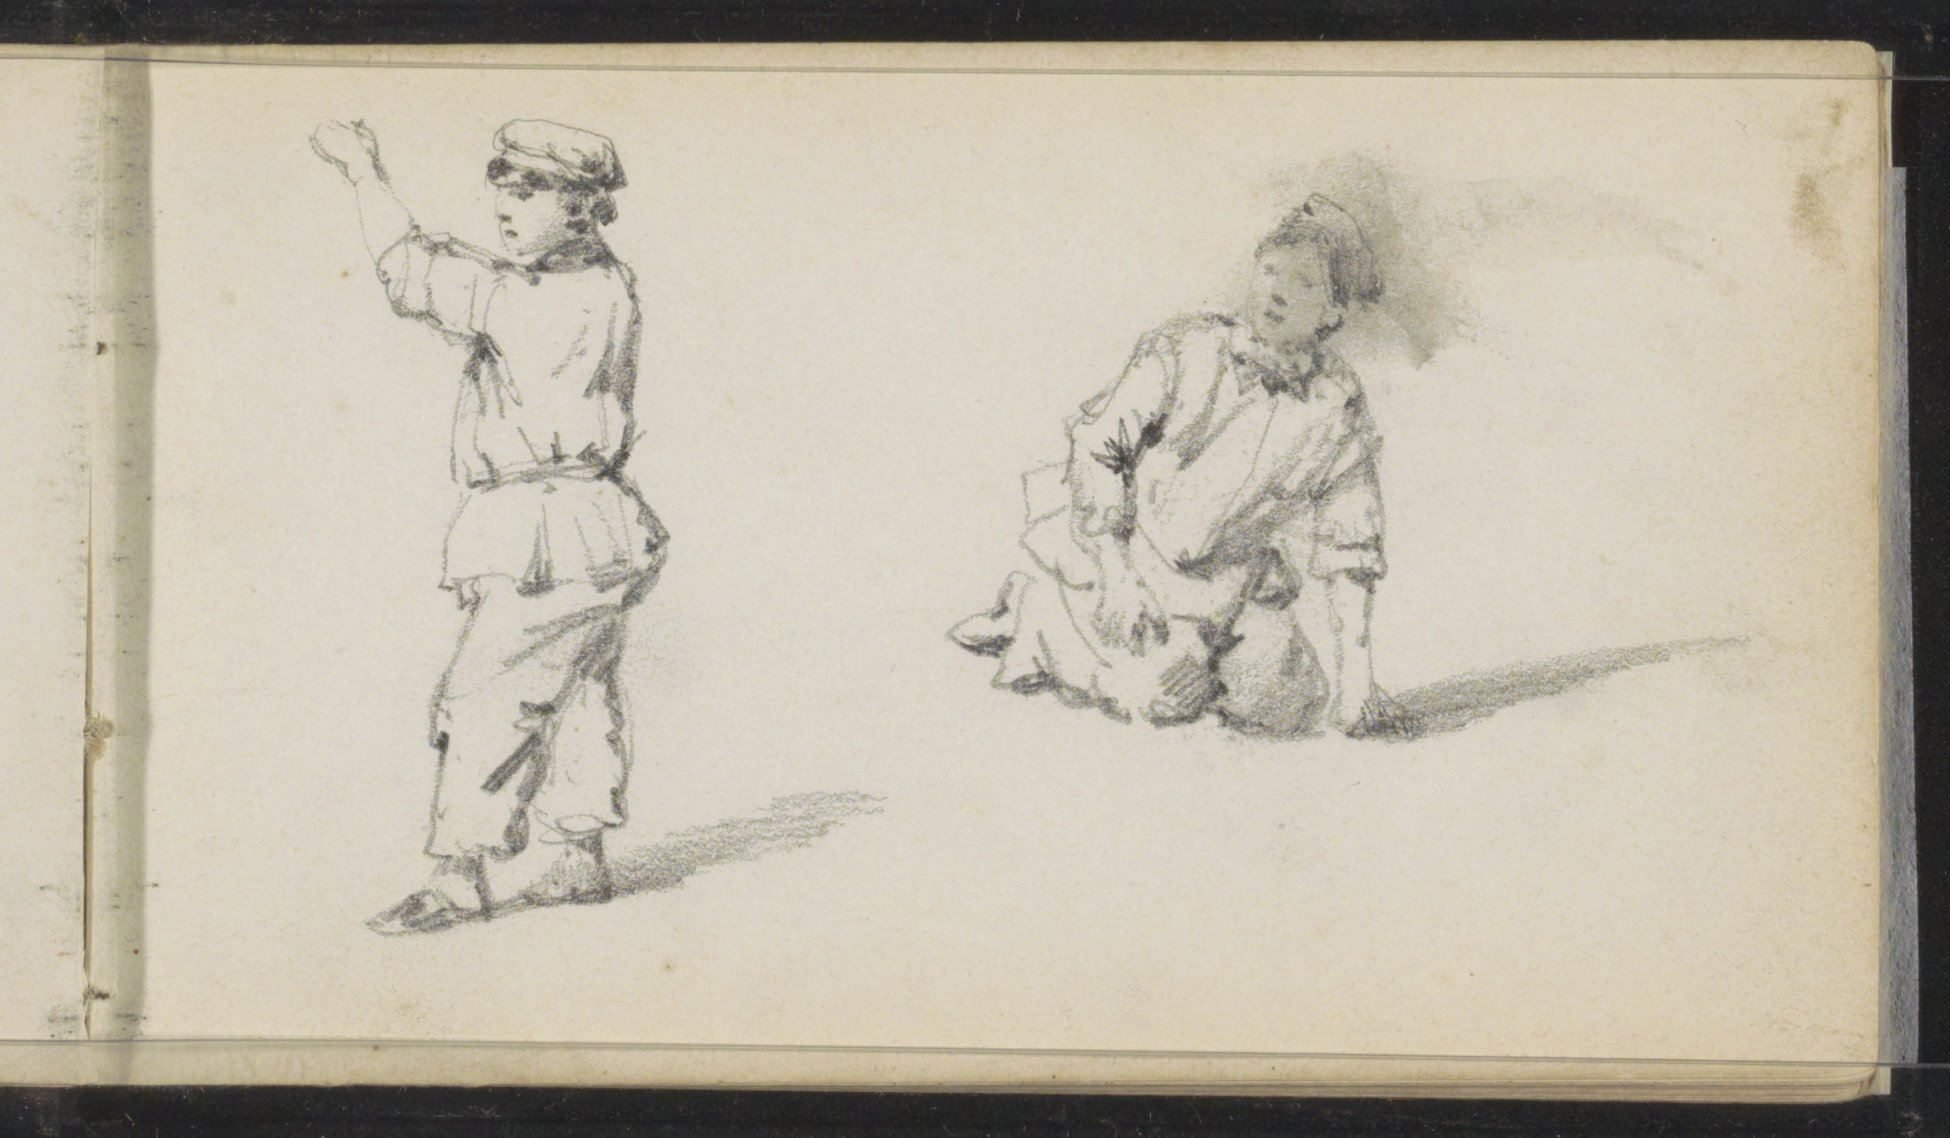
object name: sketchbook leaf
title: Twee figuren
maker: cornelis springer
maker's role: draughtsman, painter, print maker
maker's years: 1817-1891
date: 1860-1866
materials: paper, pencil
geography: netherlands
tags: standing figure, kneeling on both knees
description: Een staande jongen en een knielende man. Blad 8 uit een schetsboek met 44 bladen.